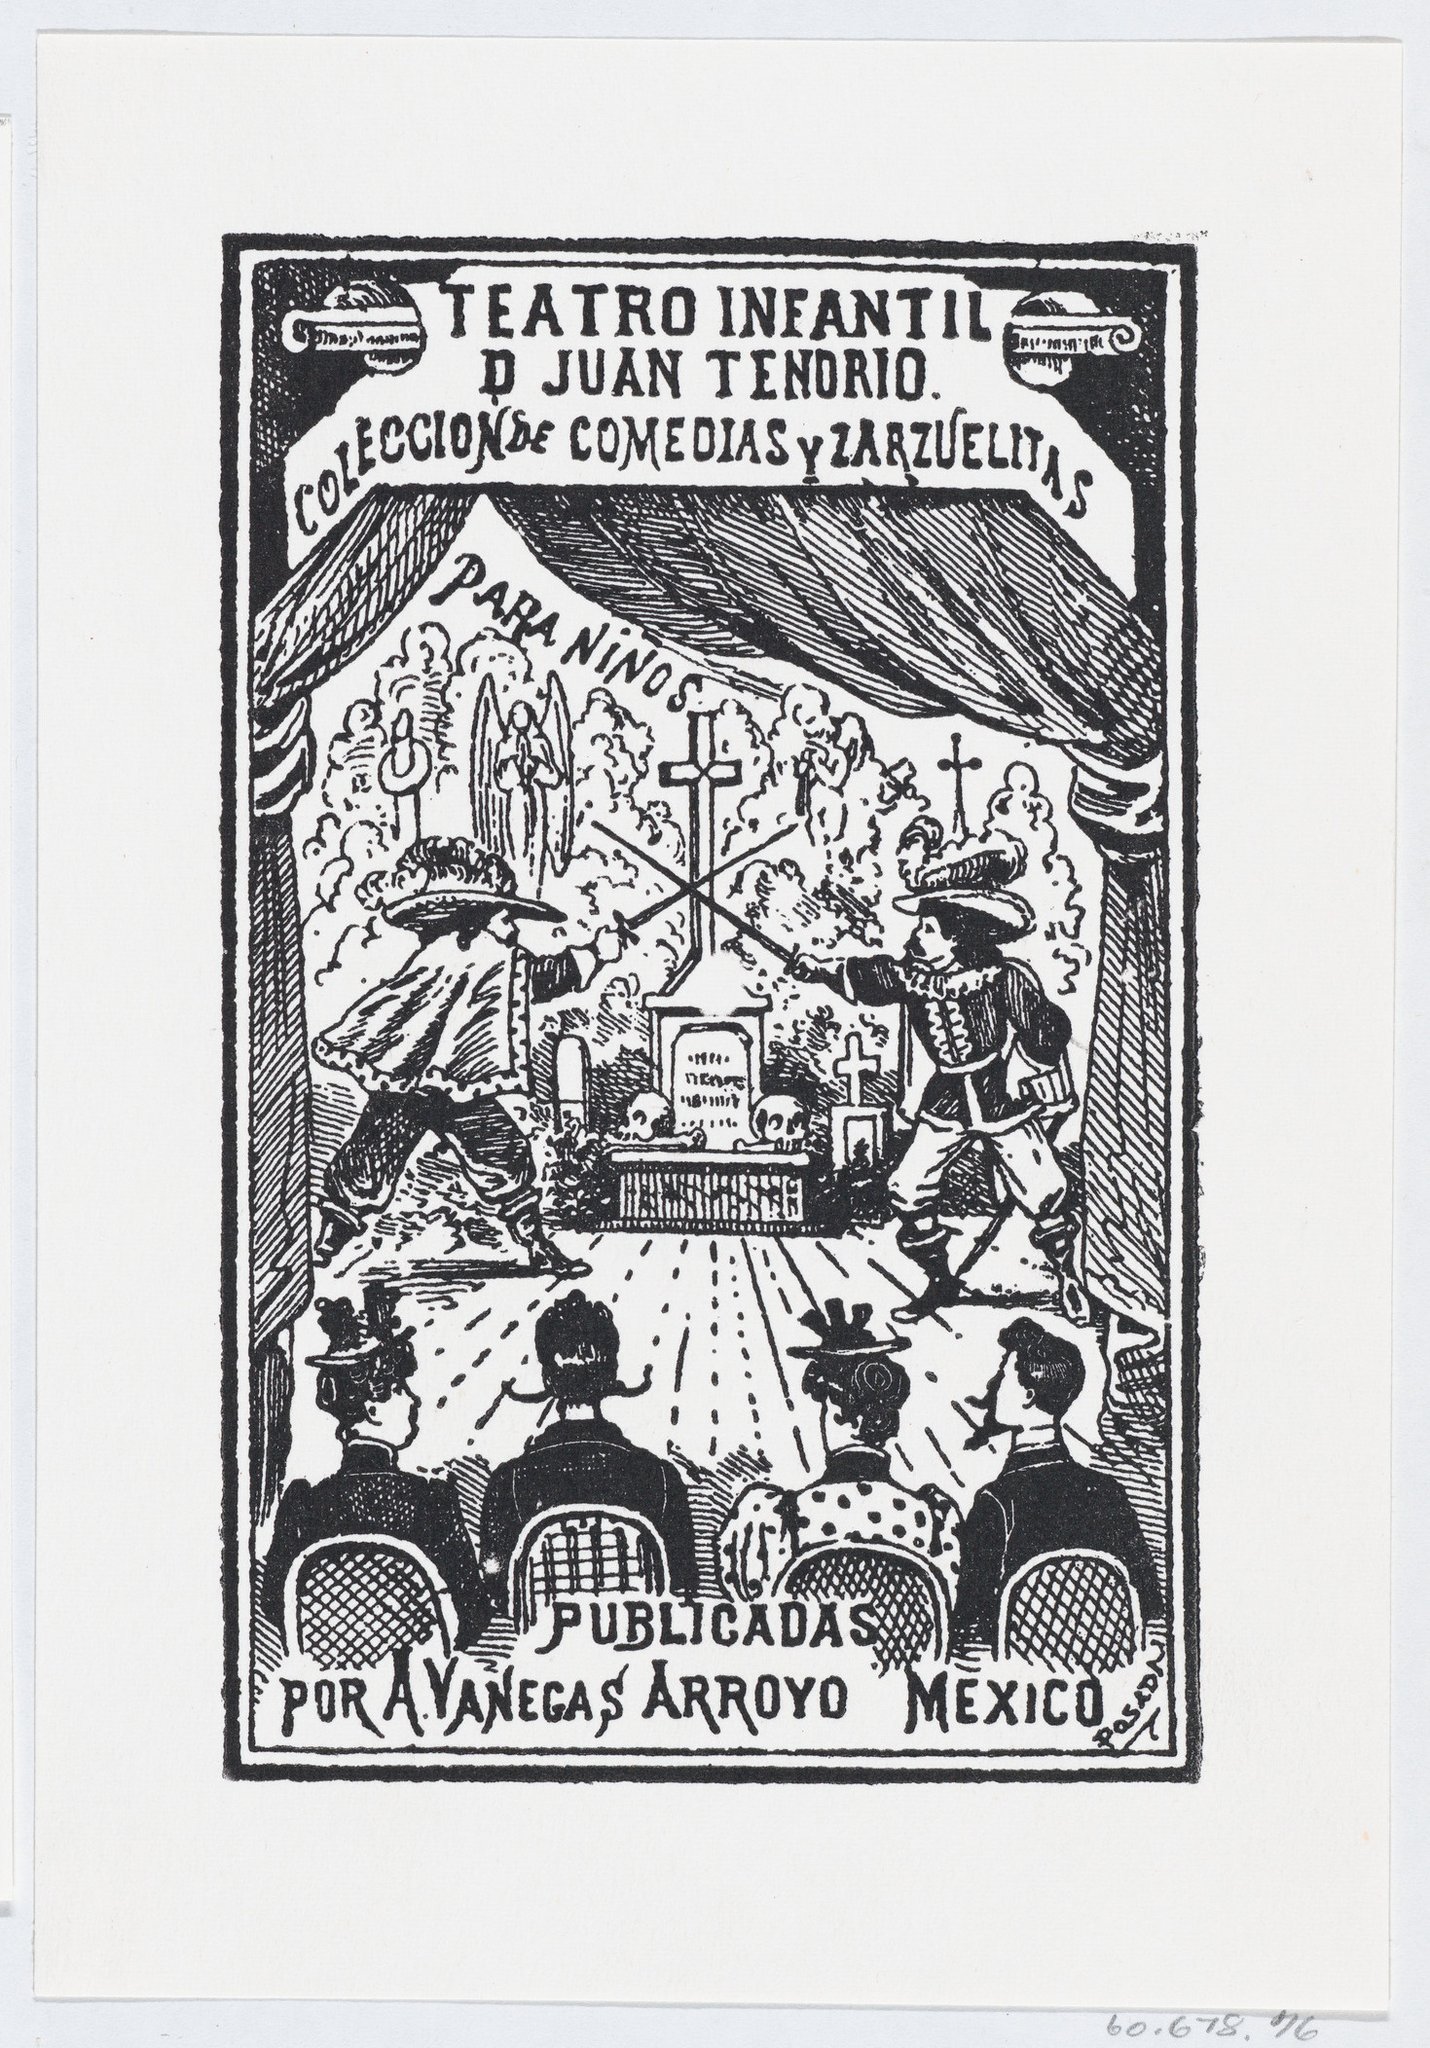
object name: print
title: Two men dueling on a stage in front of an audience, illustration for 'Teatro Infantil de Juan Tendrio'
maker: josé guadalupe posada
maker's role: artist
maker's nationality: mexican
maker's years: 1852-1913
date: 1898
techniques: lithography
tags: theatre,men,spectators,actors